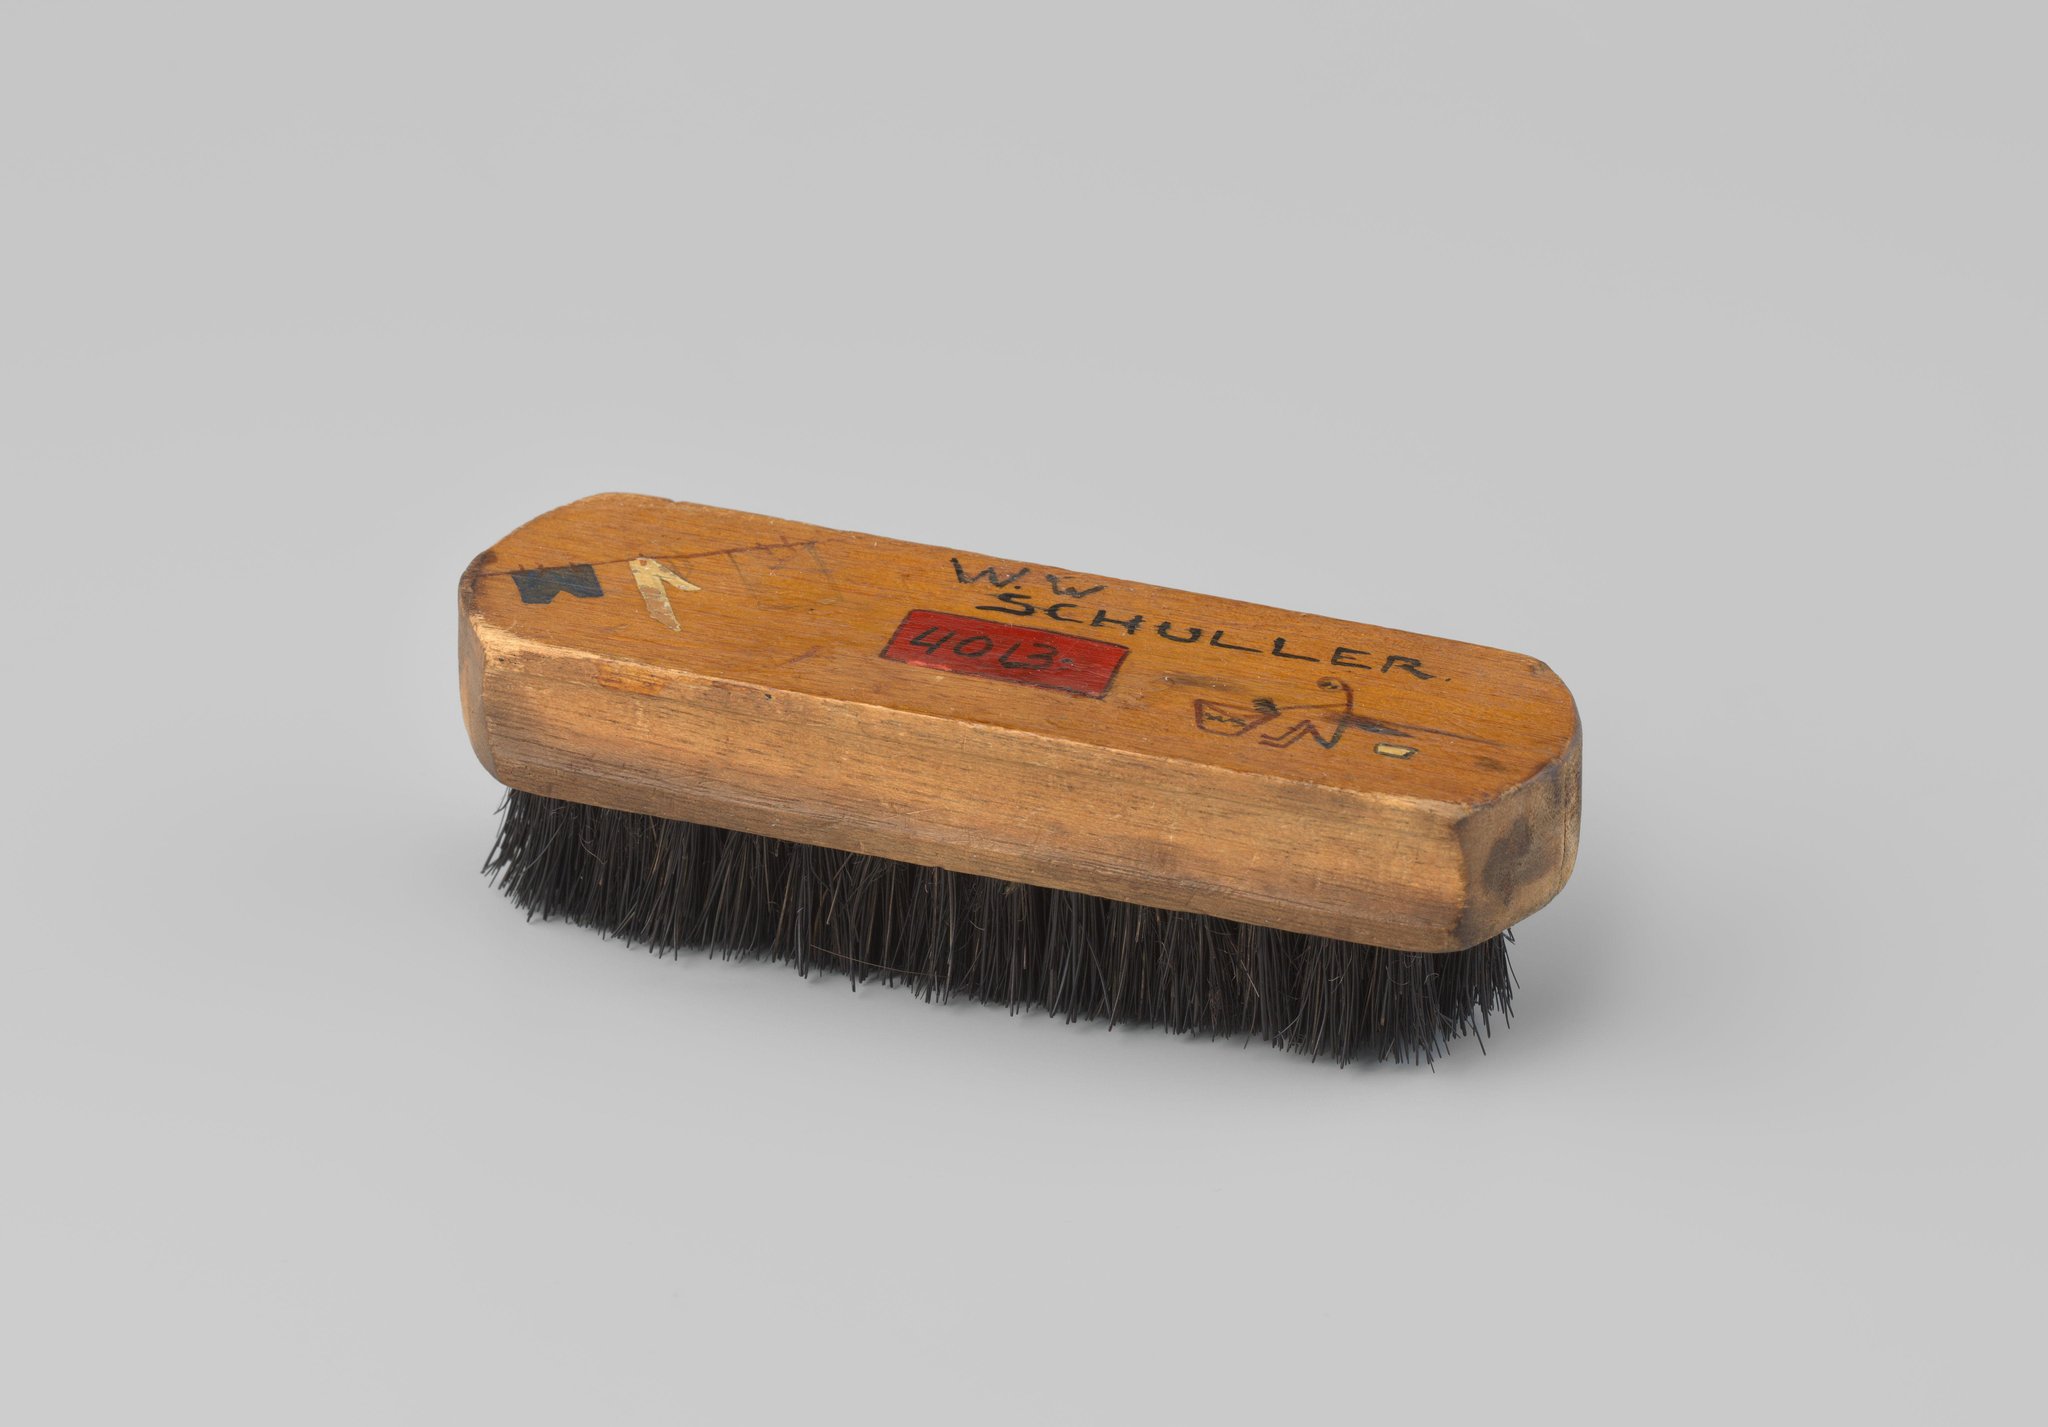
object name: brush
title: Wasborstel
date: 1944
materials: paint, watercolor, wood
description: "Wasborstel, hout, beschilderd met plakkaatverf. Met o.a. het oude P.O.W.-nummer 4013. Gemaakt door Toos in Tjideng op 27 augustus 1944." [Beschrijving Wim Schüller, Inventaris van de Grogoldoos, 1994/5]